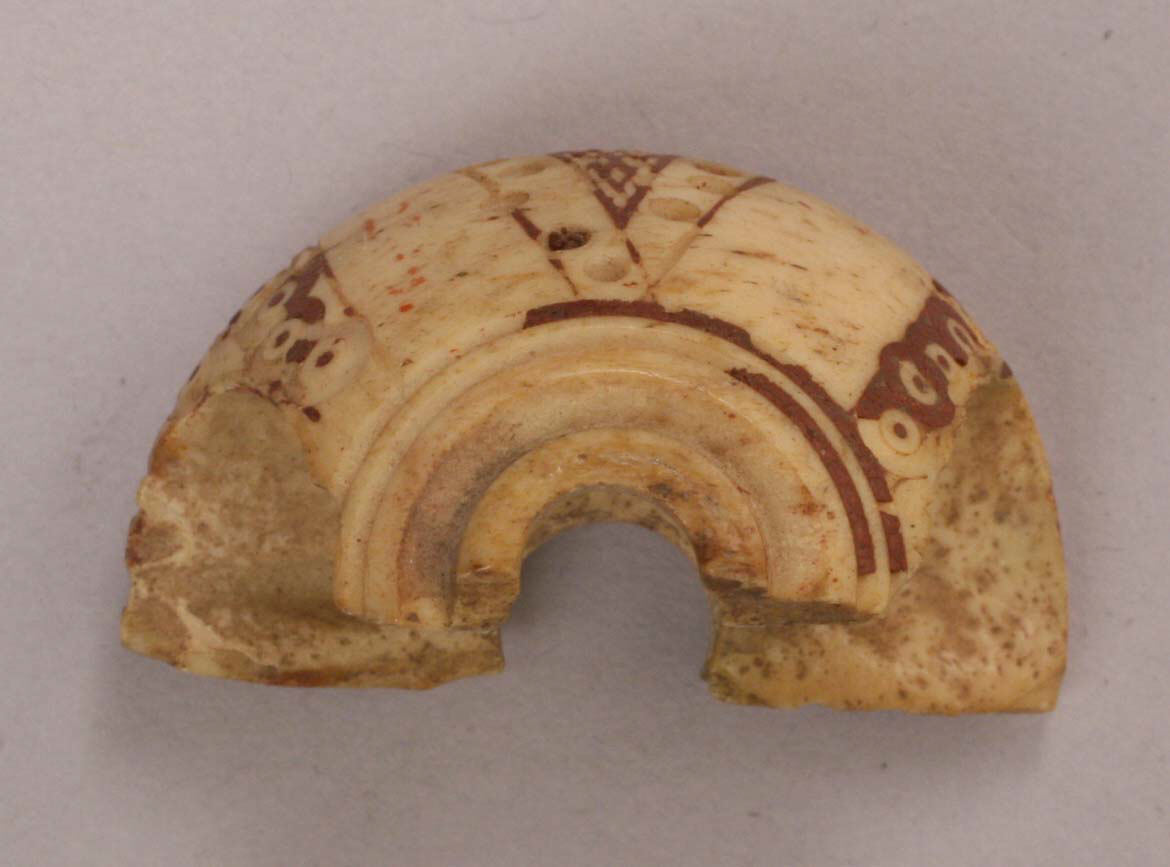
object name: button or spindle whorl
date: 201-1000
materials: bone, paint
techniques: incising, inlay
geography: egypt